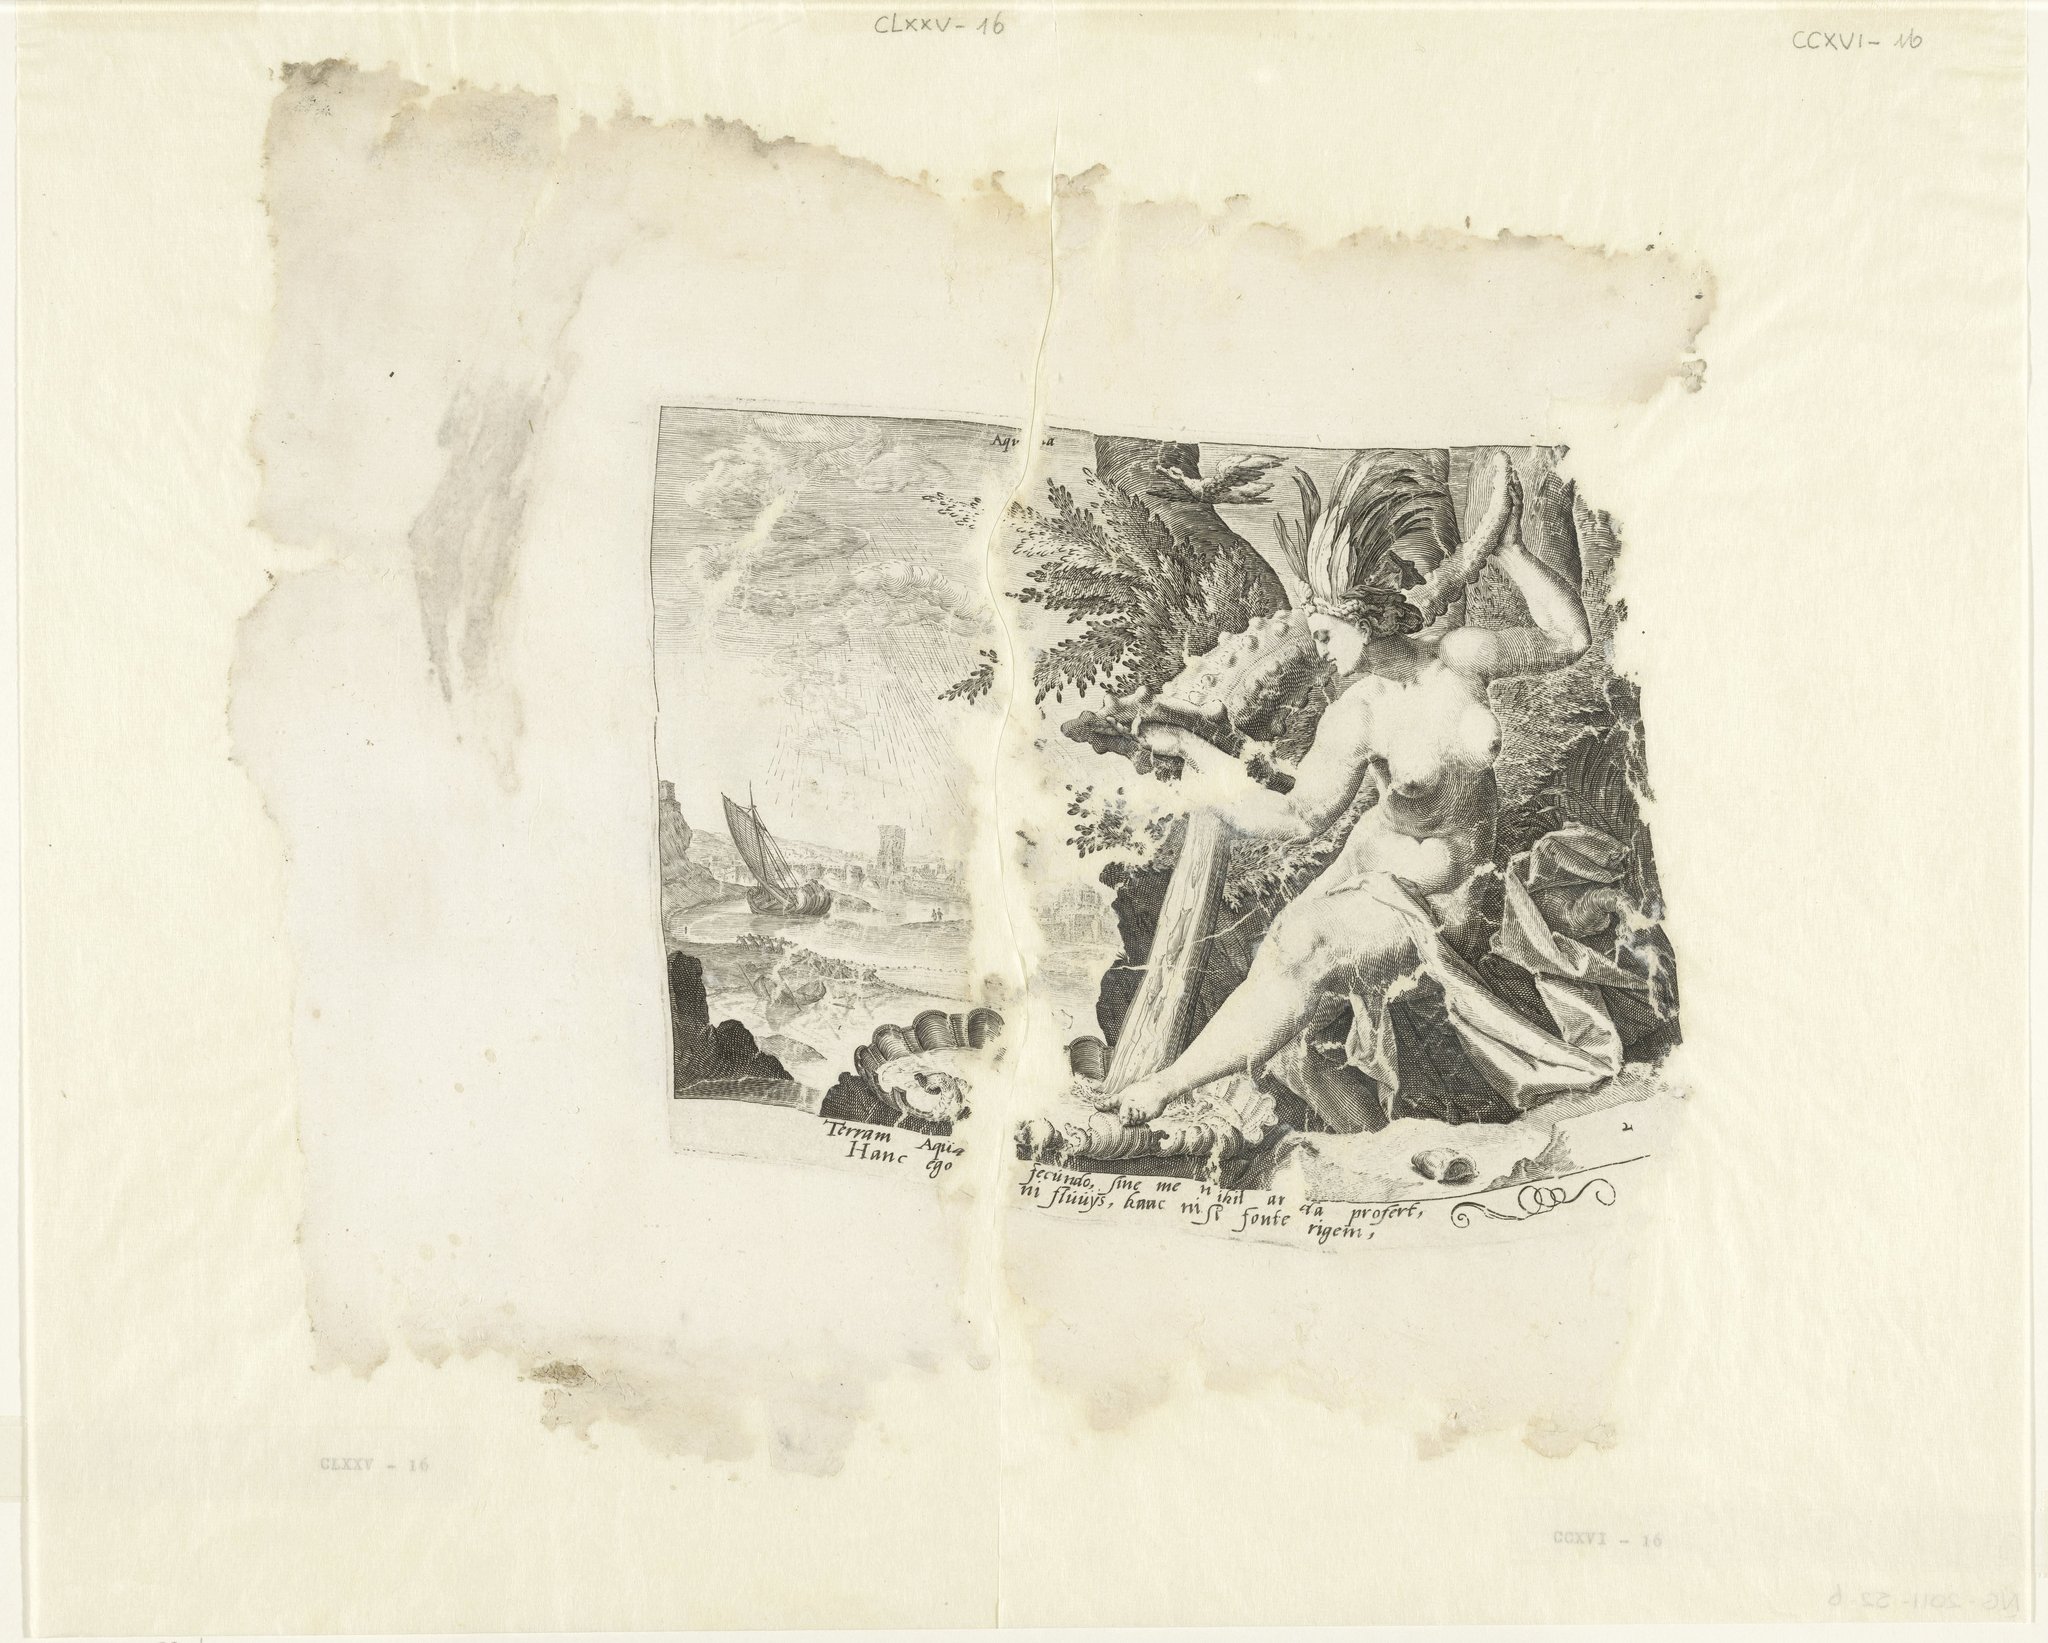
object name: print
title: Water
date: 1580-1596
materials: paper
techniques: engraving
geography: amsterdam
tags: water (one of the four elements)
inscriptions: watermark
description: De prenten in de Nova Zembla collectie zijn tijdens een expeditie van Willem Barendsz en Jacob van Heemskerk in 1596-1597 noodgedwongen in het winterkamp, het ‘Behouden Huis’, op het eiland achtergelaten. De prenten waren in één of meerdere stapels als handelswaar meegenomen vanuit Amsterdam. Bijna drie eeuwen later, in 1871, keerde de Noor Elling Carlsen terug naar Nova Zembla en vond daar de restanten van het ‘Behouden Huis, inclusief een groot deel van de inventaris. Een deel van de prenten, in de vorm van aaneengekoekte kluiten, werd toen ook teruggevonden. De papierkluiten waren soms op meerdere plekken gebroken. Tussen 1975-1979 zijn de prenten van elkaar gescheiden. Dit leverde in totaal ca. 1000 fragmenten van ca. 400 afdrukken van ca. 150 verschillende prenten op. Voor zover mogelijk zijn de fragmenten samengevoegd en zijn de prenten gereconstrueerd.